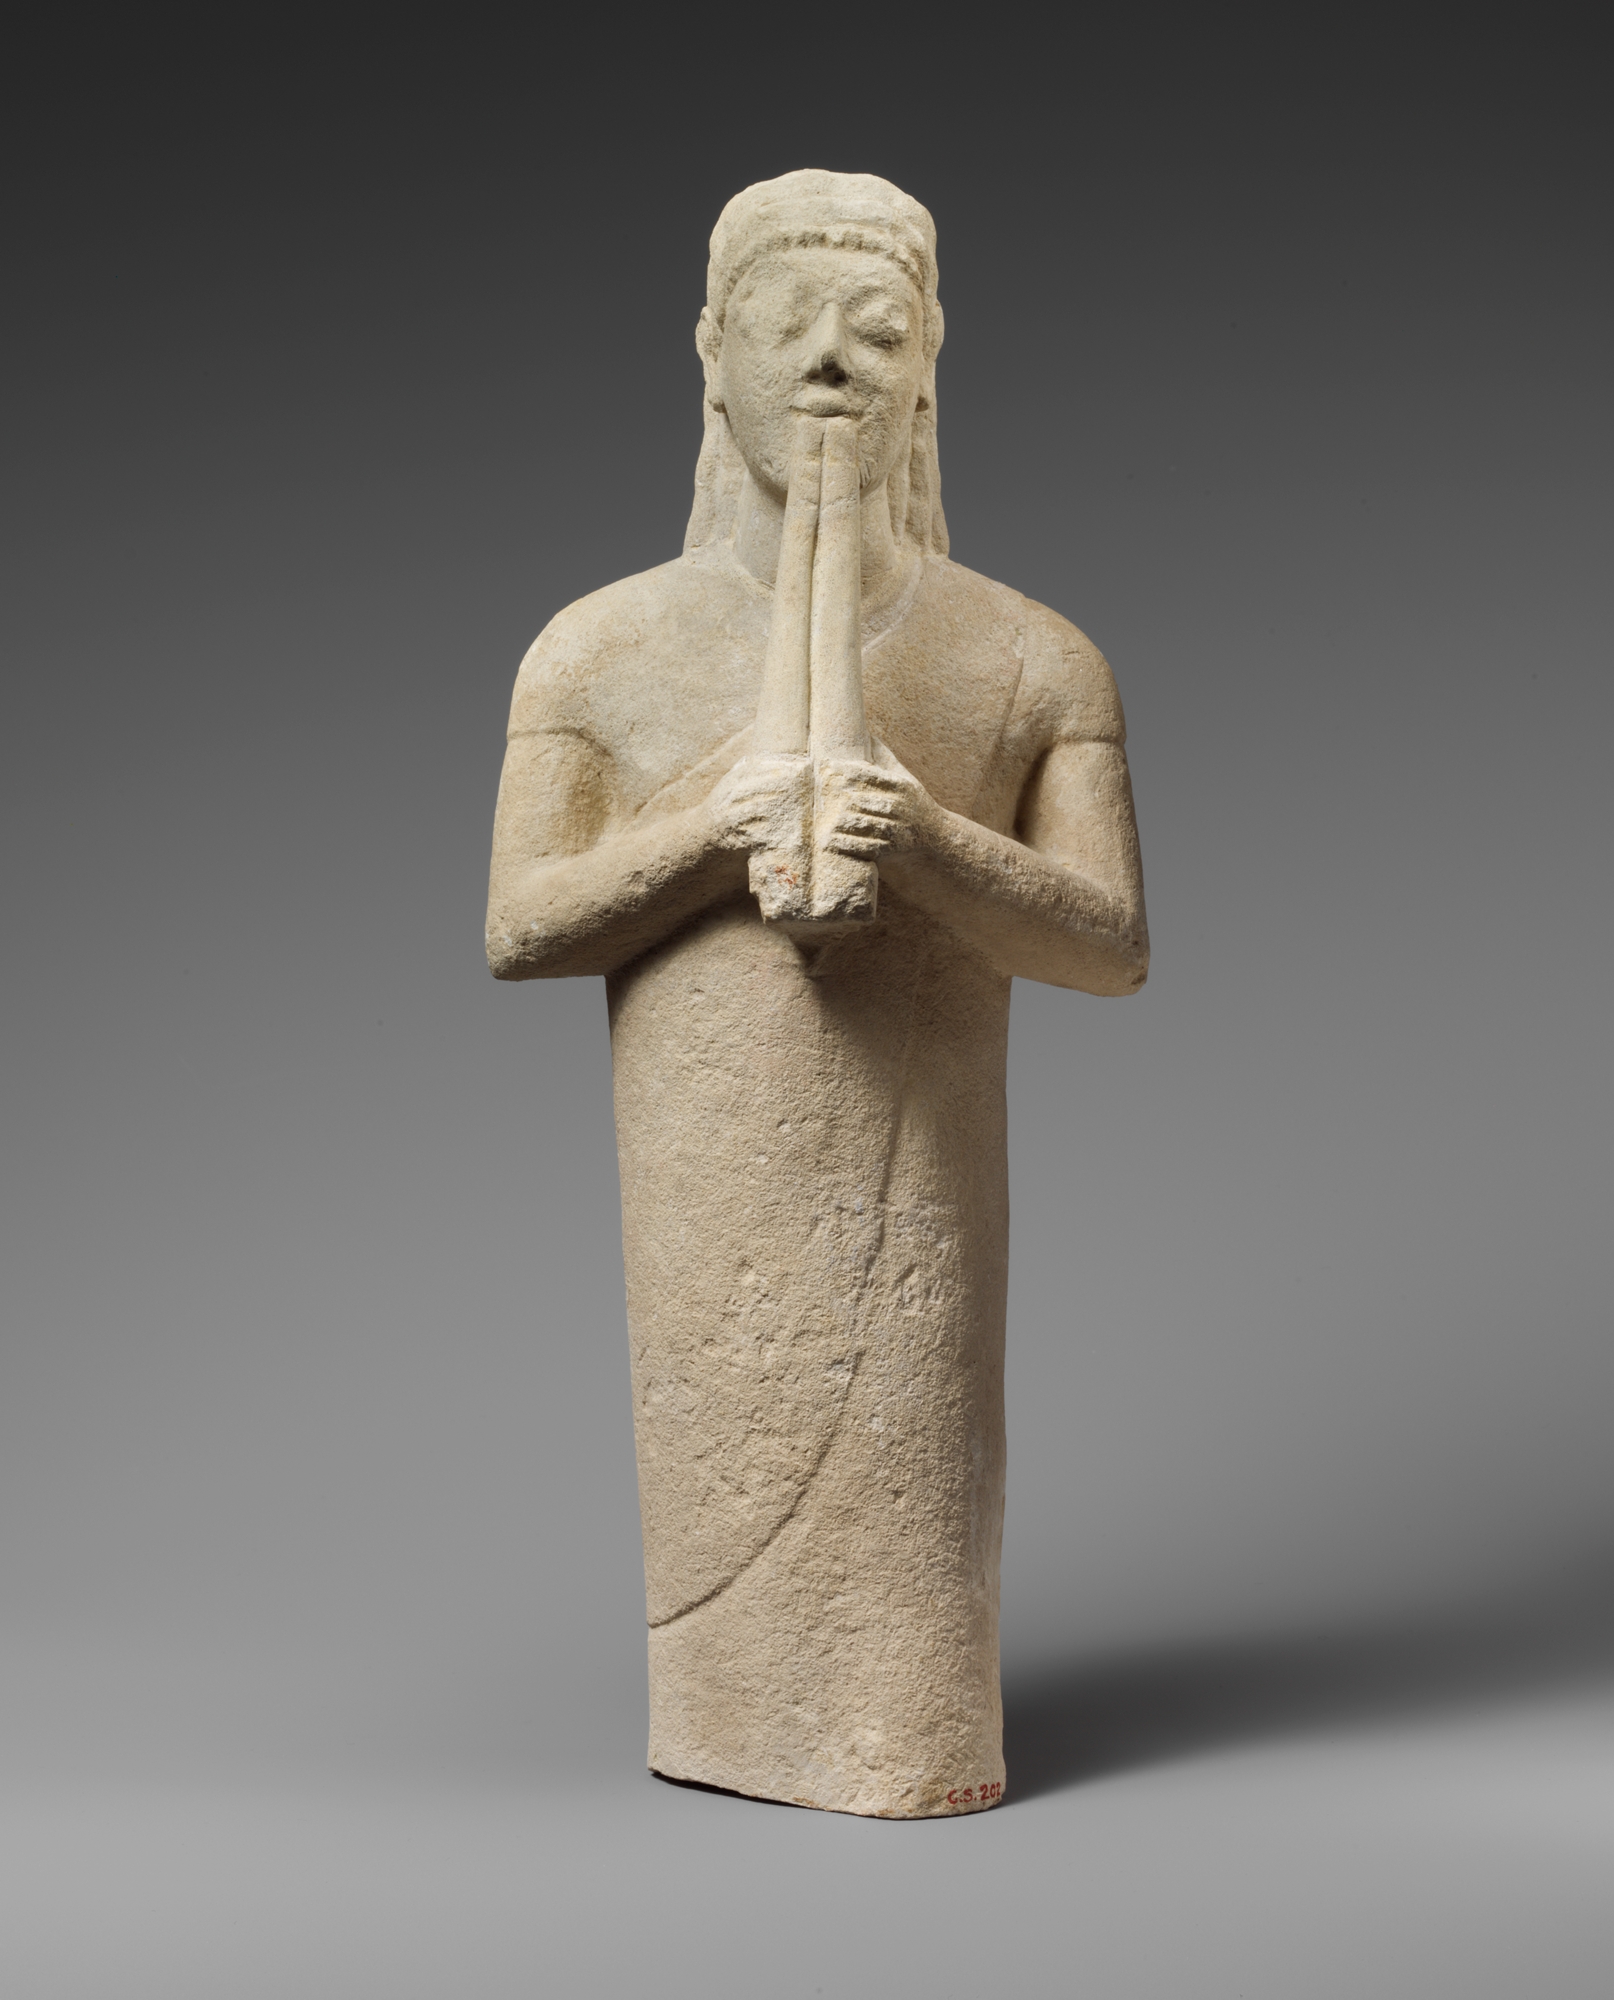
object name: statue of a flute player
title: Limestone statuette of a male aulos player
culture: cypriot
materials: limestone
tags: musical instruments,men,musicians